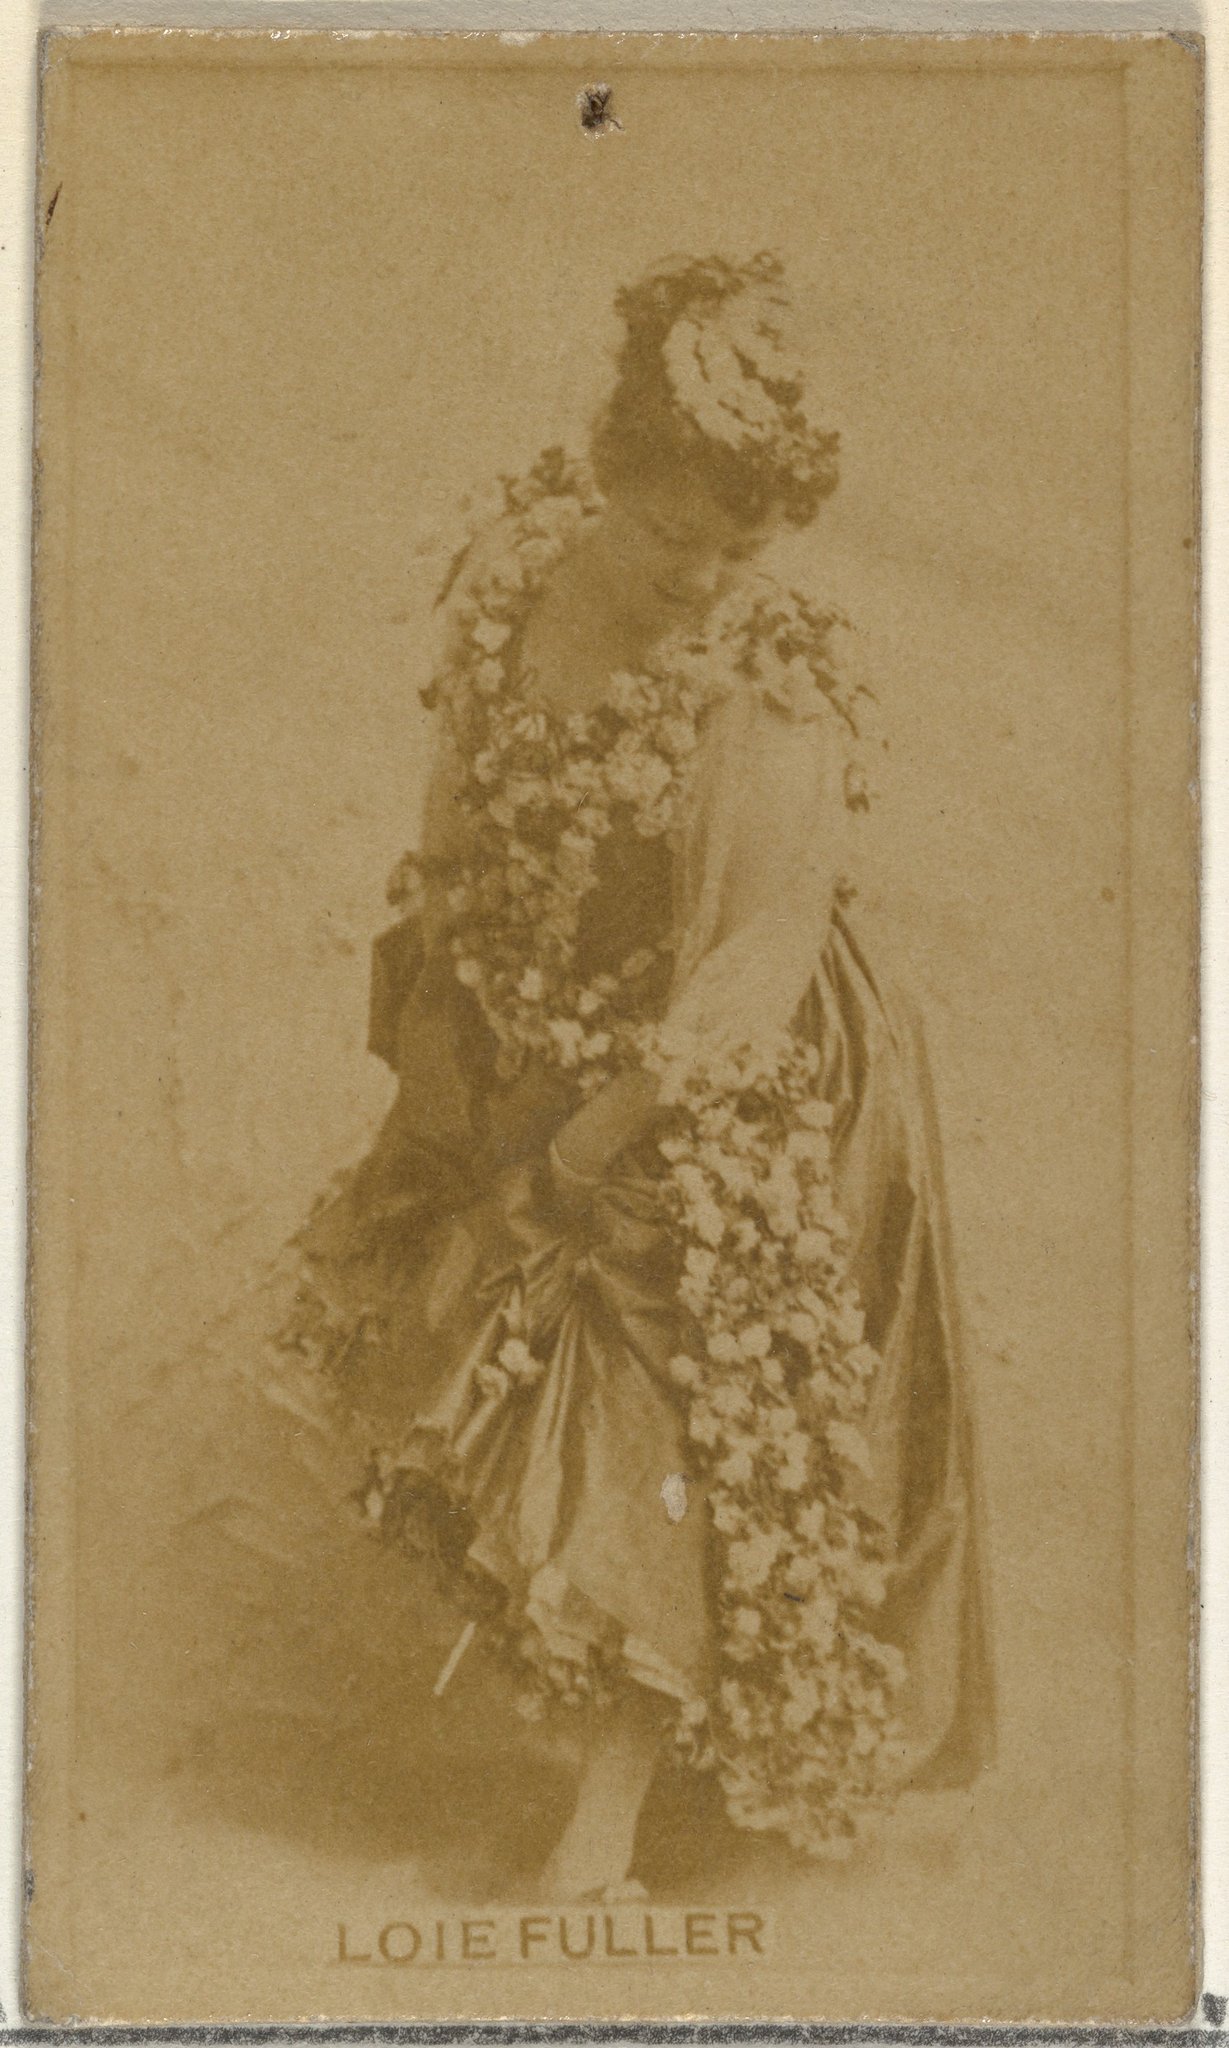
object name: photograph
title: Loie Fuller, from the Actors and Actresses series (N145-8) issued by Duke Sons & Co. to promote Duke Cigarettes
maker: w. duke, sons & co.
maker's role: publisher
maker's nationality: american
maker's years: 1870-1920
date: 1891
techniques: albumen silver print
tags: portraits,women,actresses